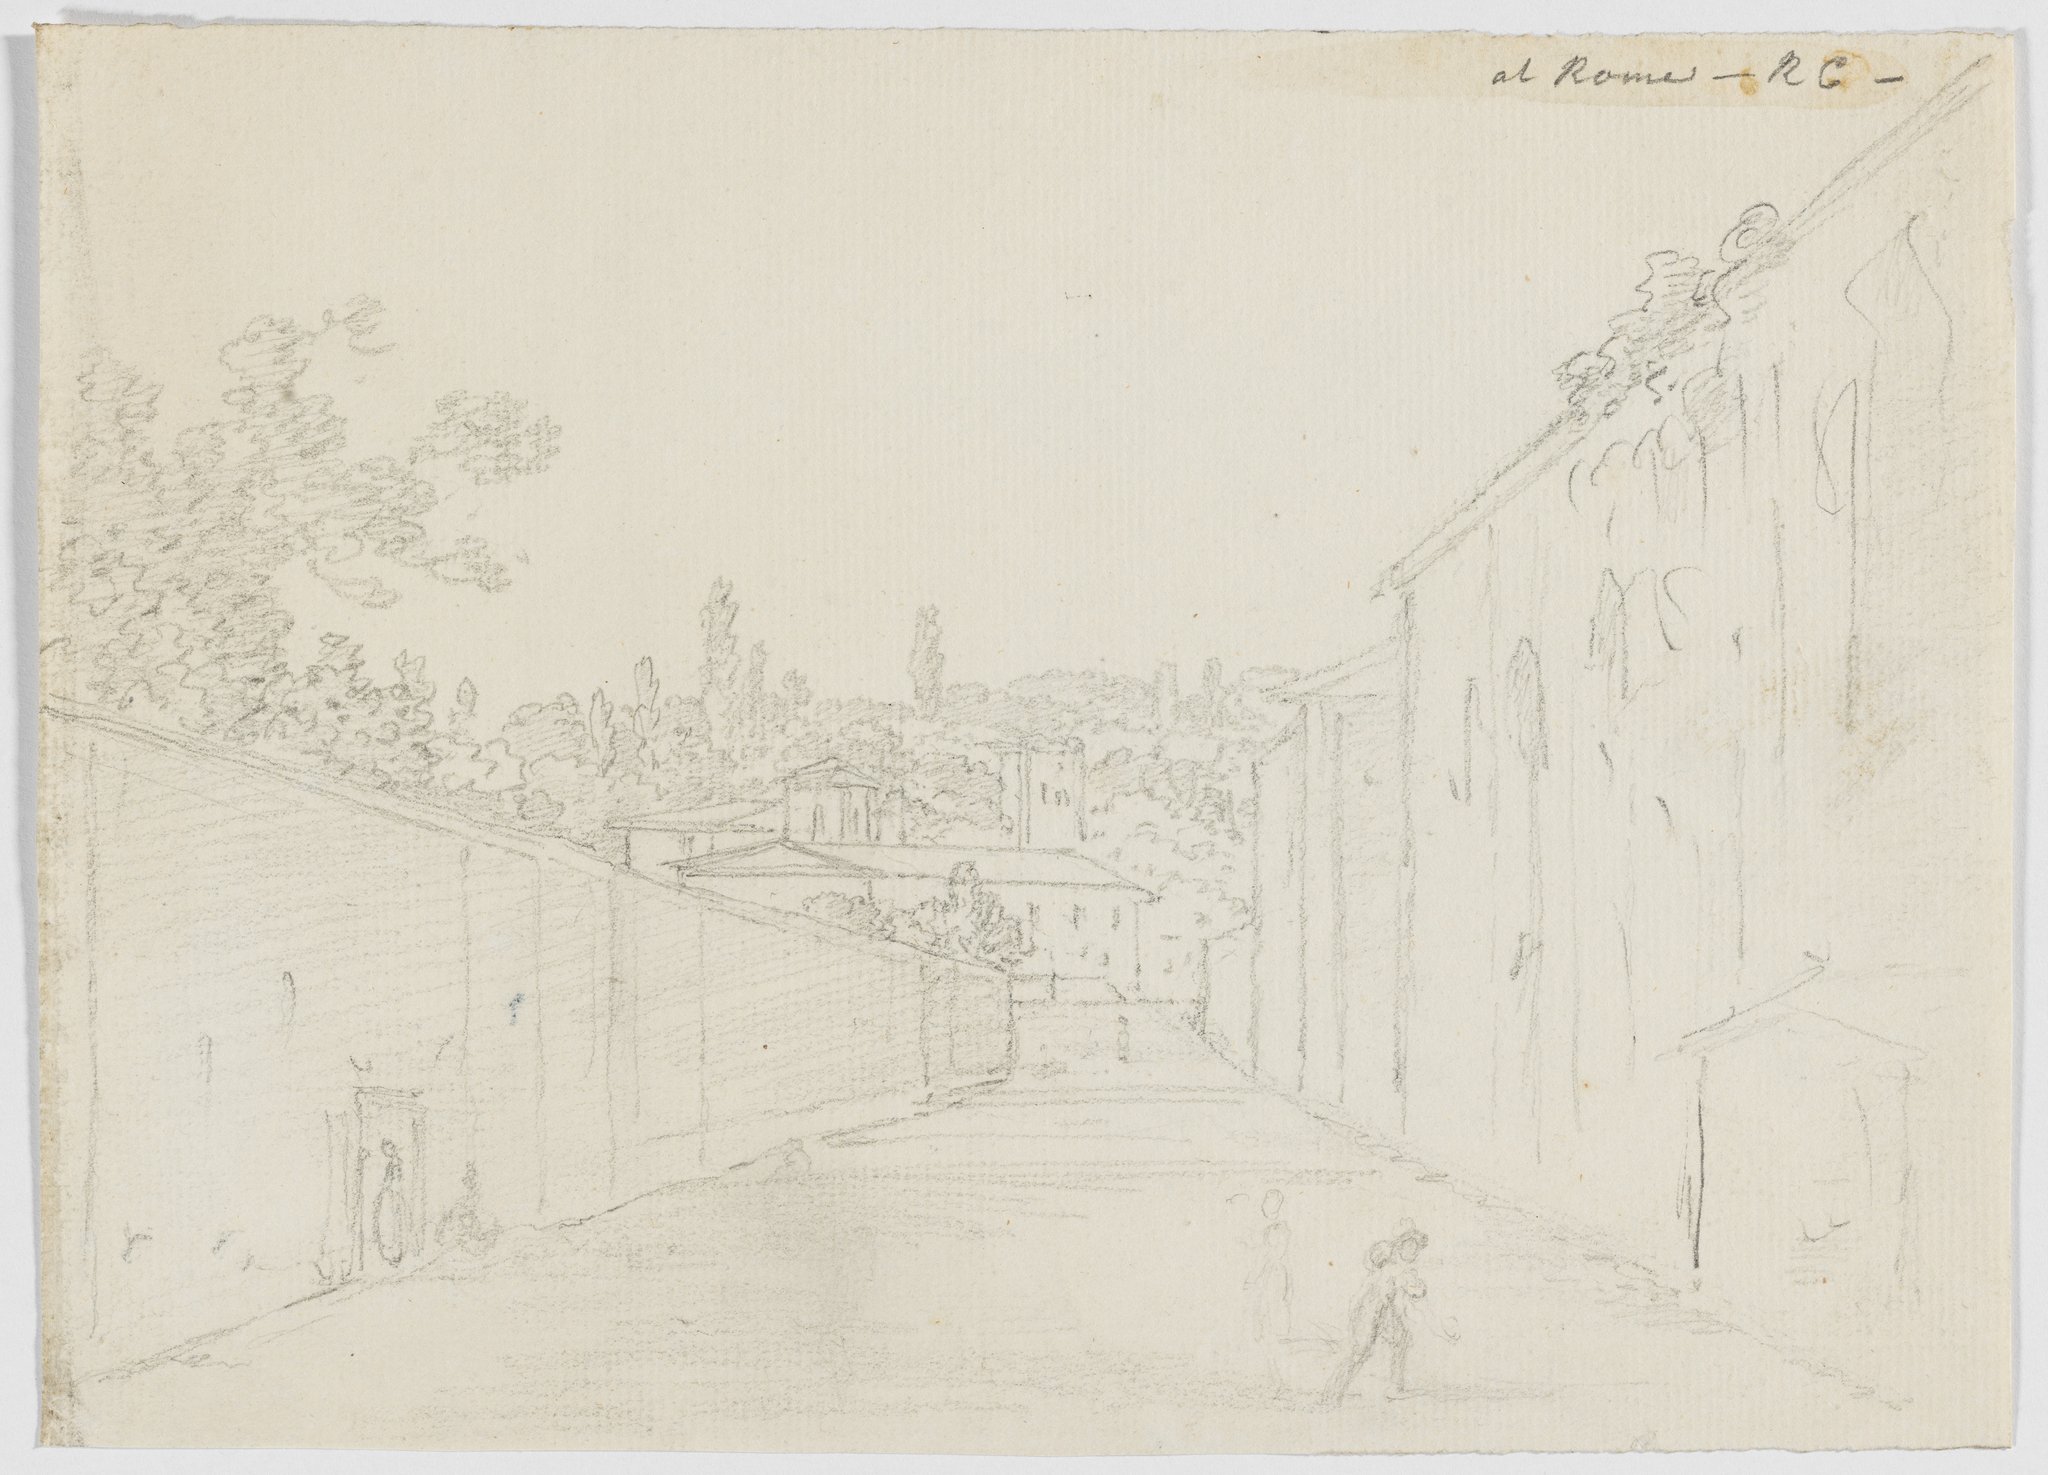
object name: drawing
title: At Rome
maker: richard cooper ii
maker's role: artist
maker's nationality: british, scottish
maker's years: 1740-1822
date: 1774-1775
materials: graphite